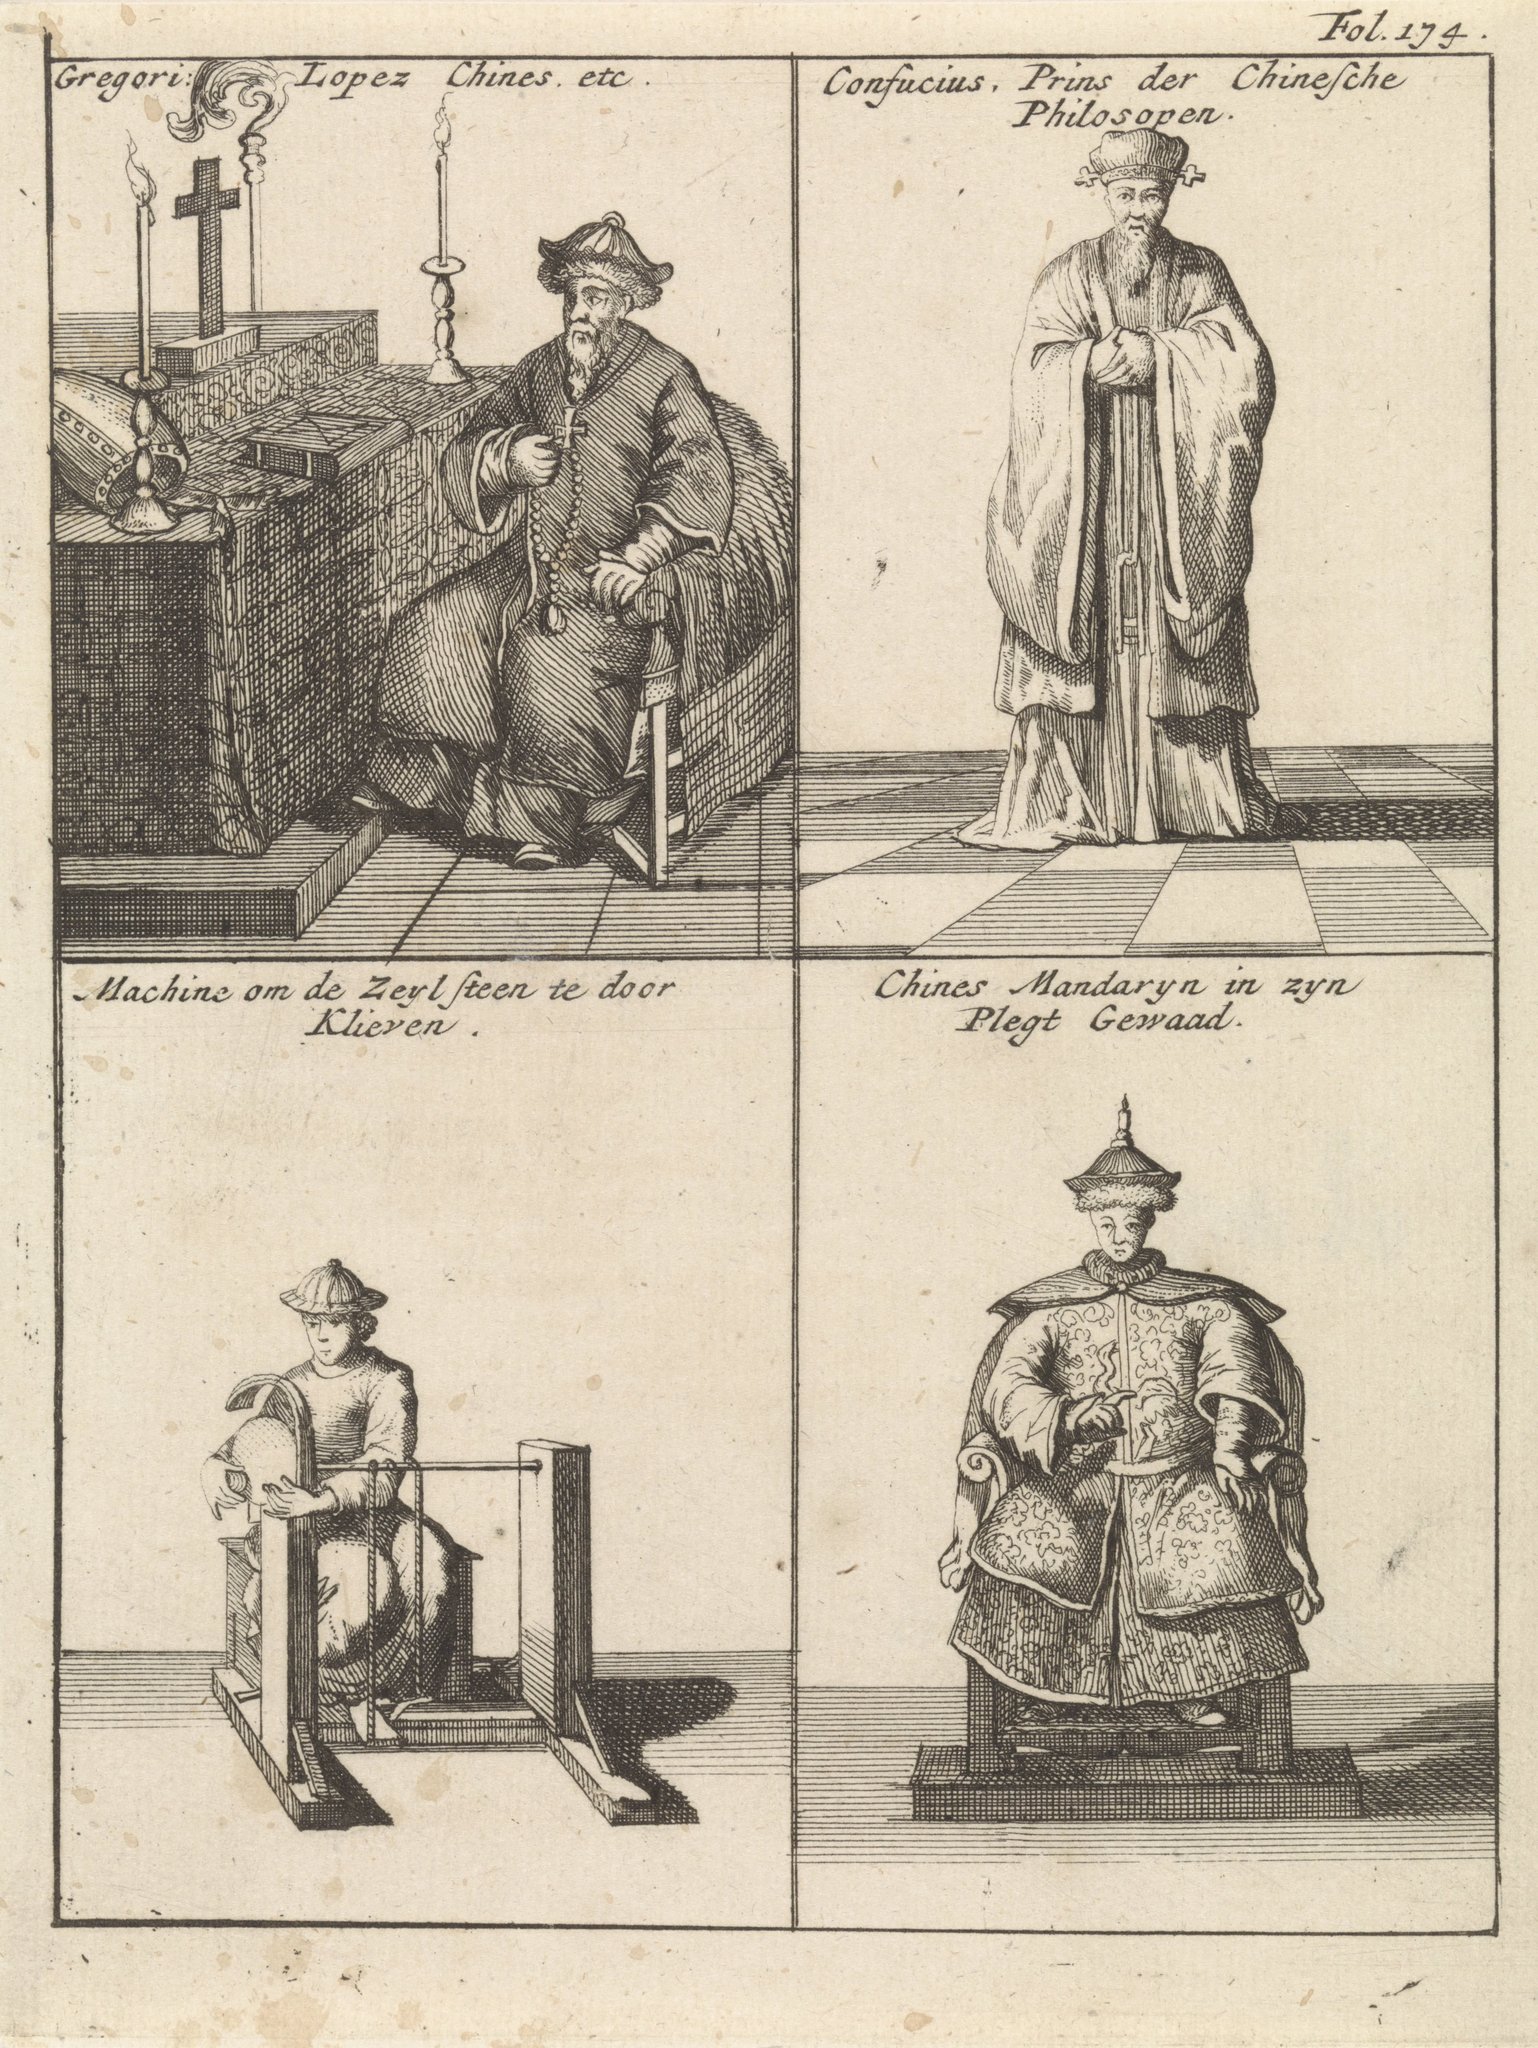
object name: book illustration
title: Chinese geestelijke / Chinese filosoof / Chinese handwerker / Chinese ambtenaar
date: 1698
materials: paper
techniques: etching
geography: amsterdam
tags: chinese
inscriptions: collector's mark: Lugt 2228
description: Illustratie uit: Le Comte, Louis. Beschryvinge van het machtige keyserryk China, 2 delen. Den Haag: Engelbrecht Boucquet, 1698.